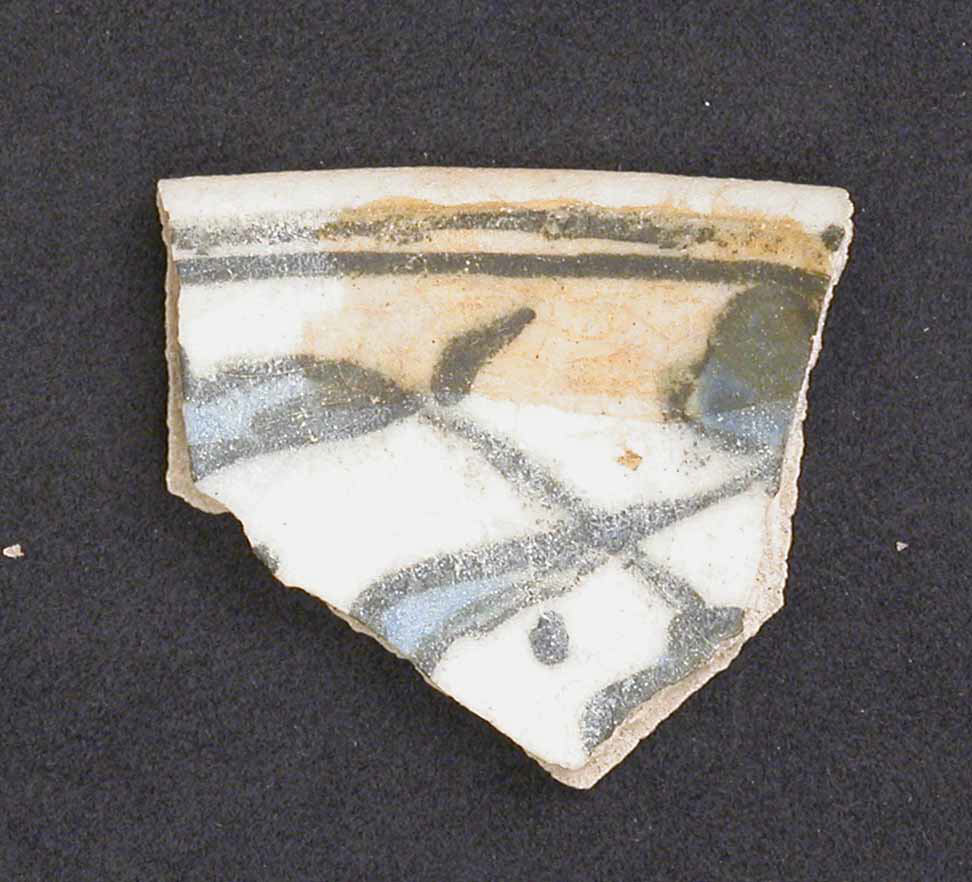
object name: fragment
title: Ceramic Fragment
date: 1201-1600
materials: stonepaste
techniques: glazing, painting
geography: saudi arabia